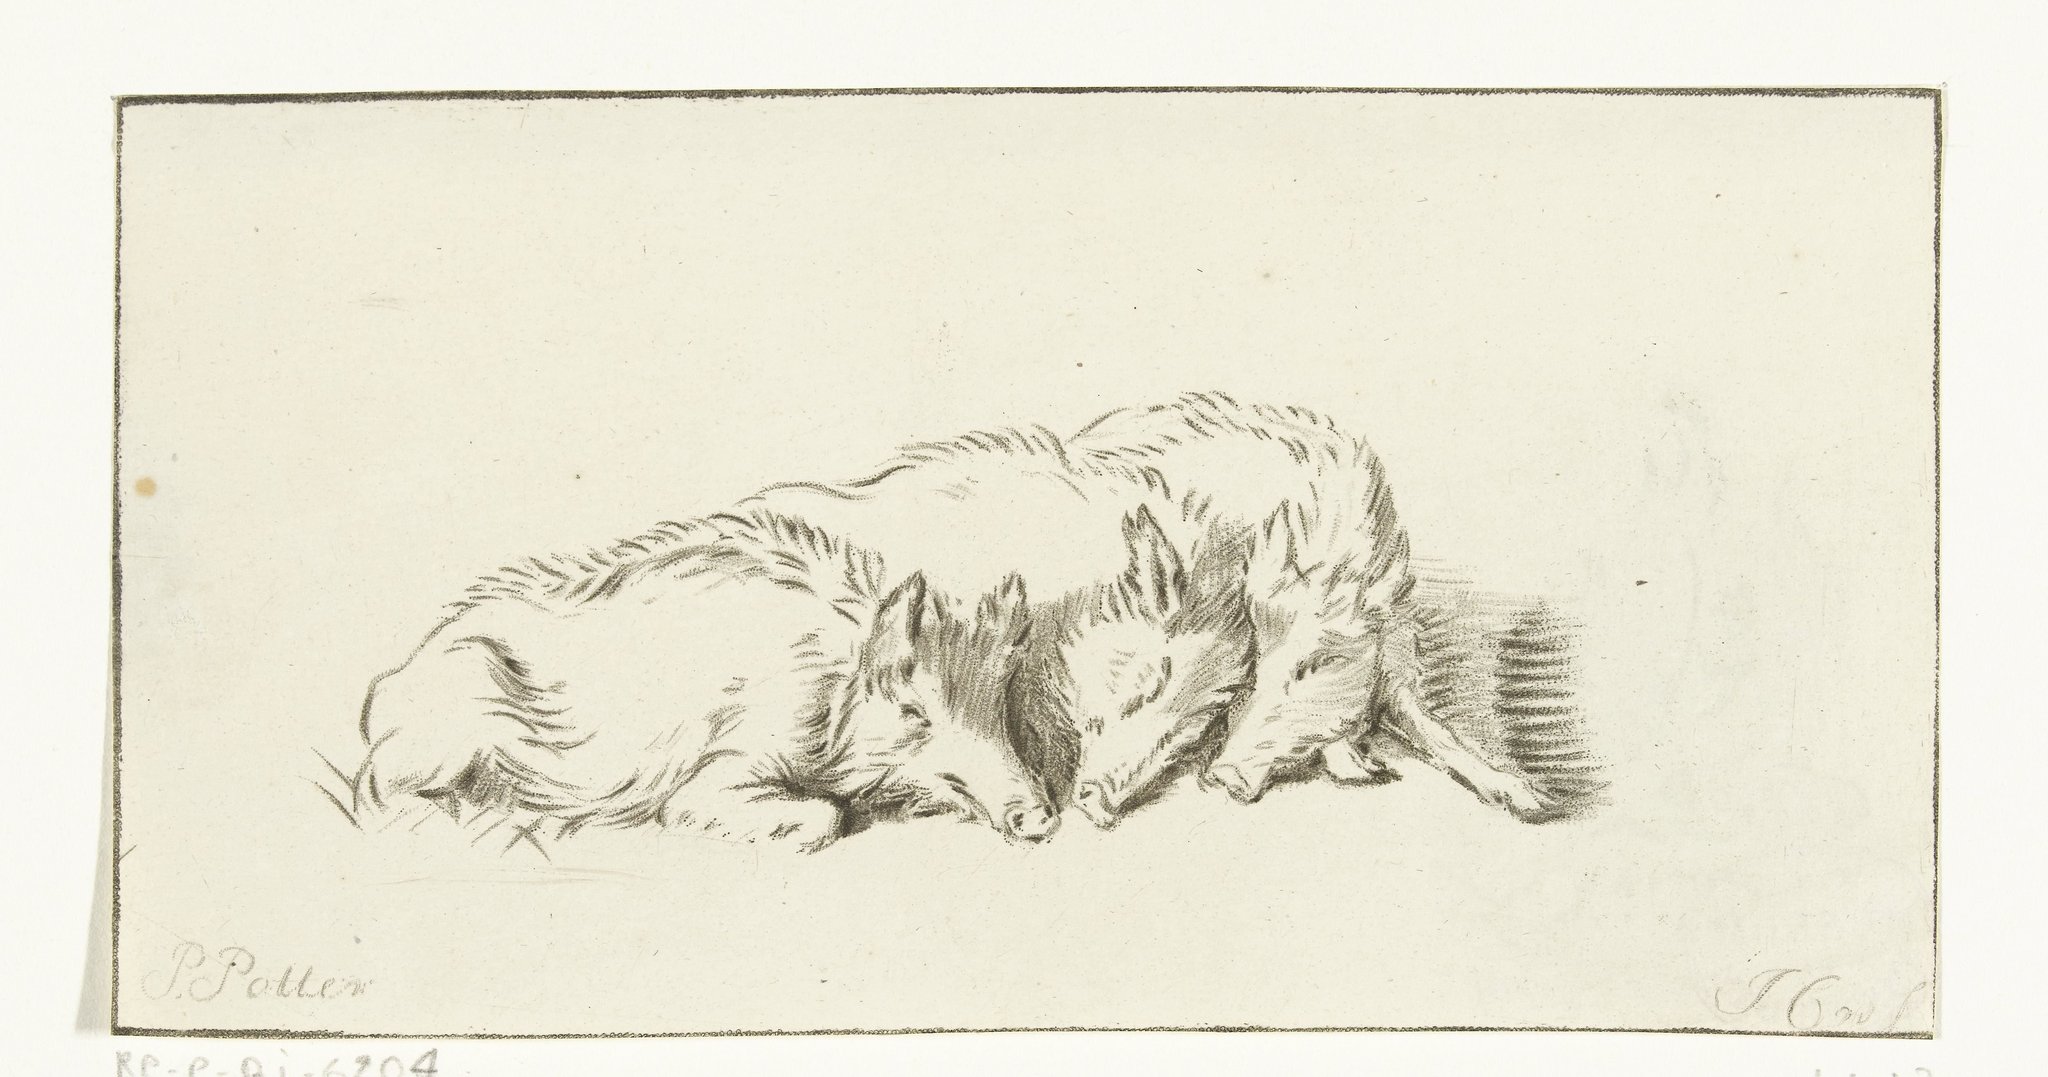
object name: print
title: Drie liggende zwijnen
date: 1724-1798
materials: paper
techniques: printmaking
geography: amsterdam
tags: hoofed animals: boar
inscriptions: collector's mark: Lugt 2725, collector's mark: Lugt 12